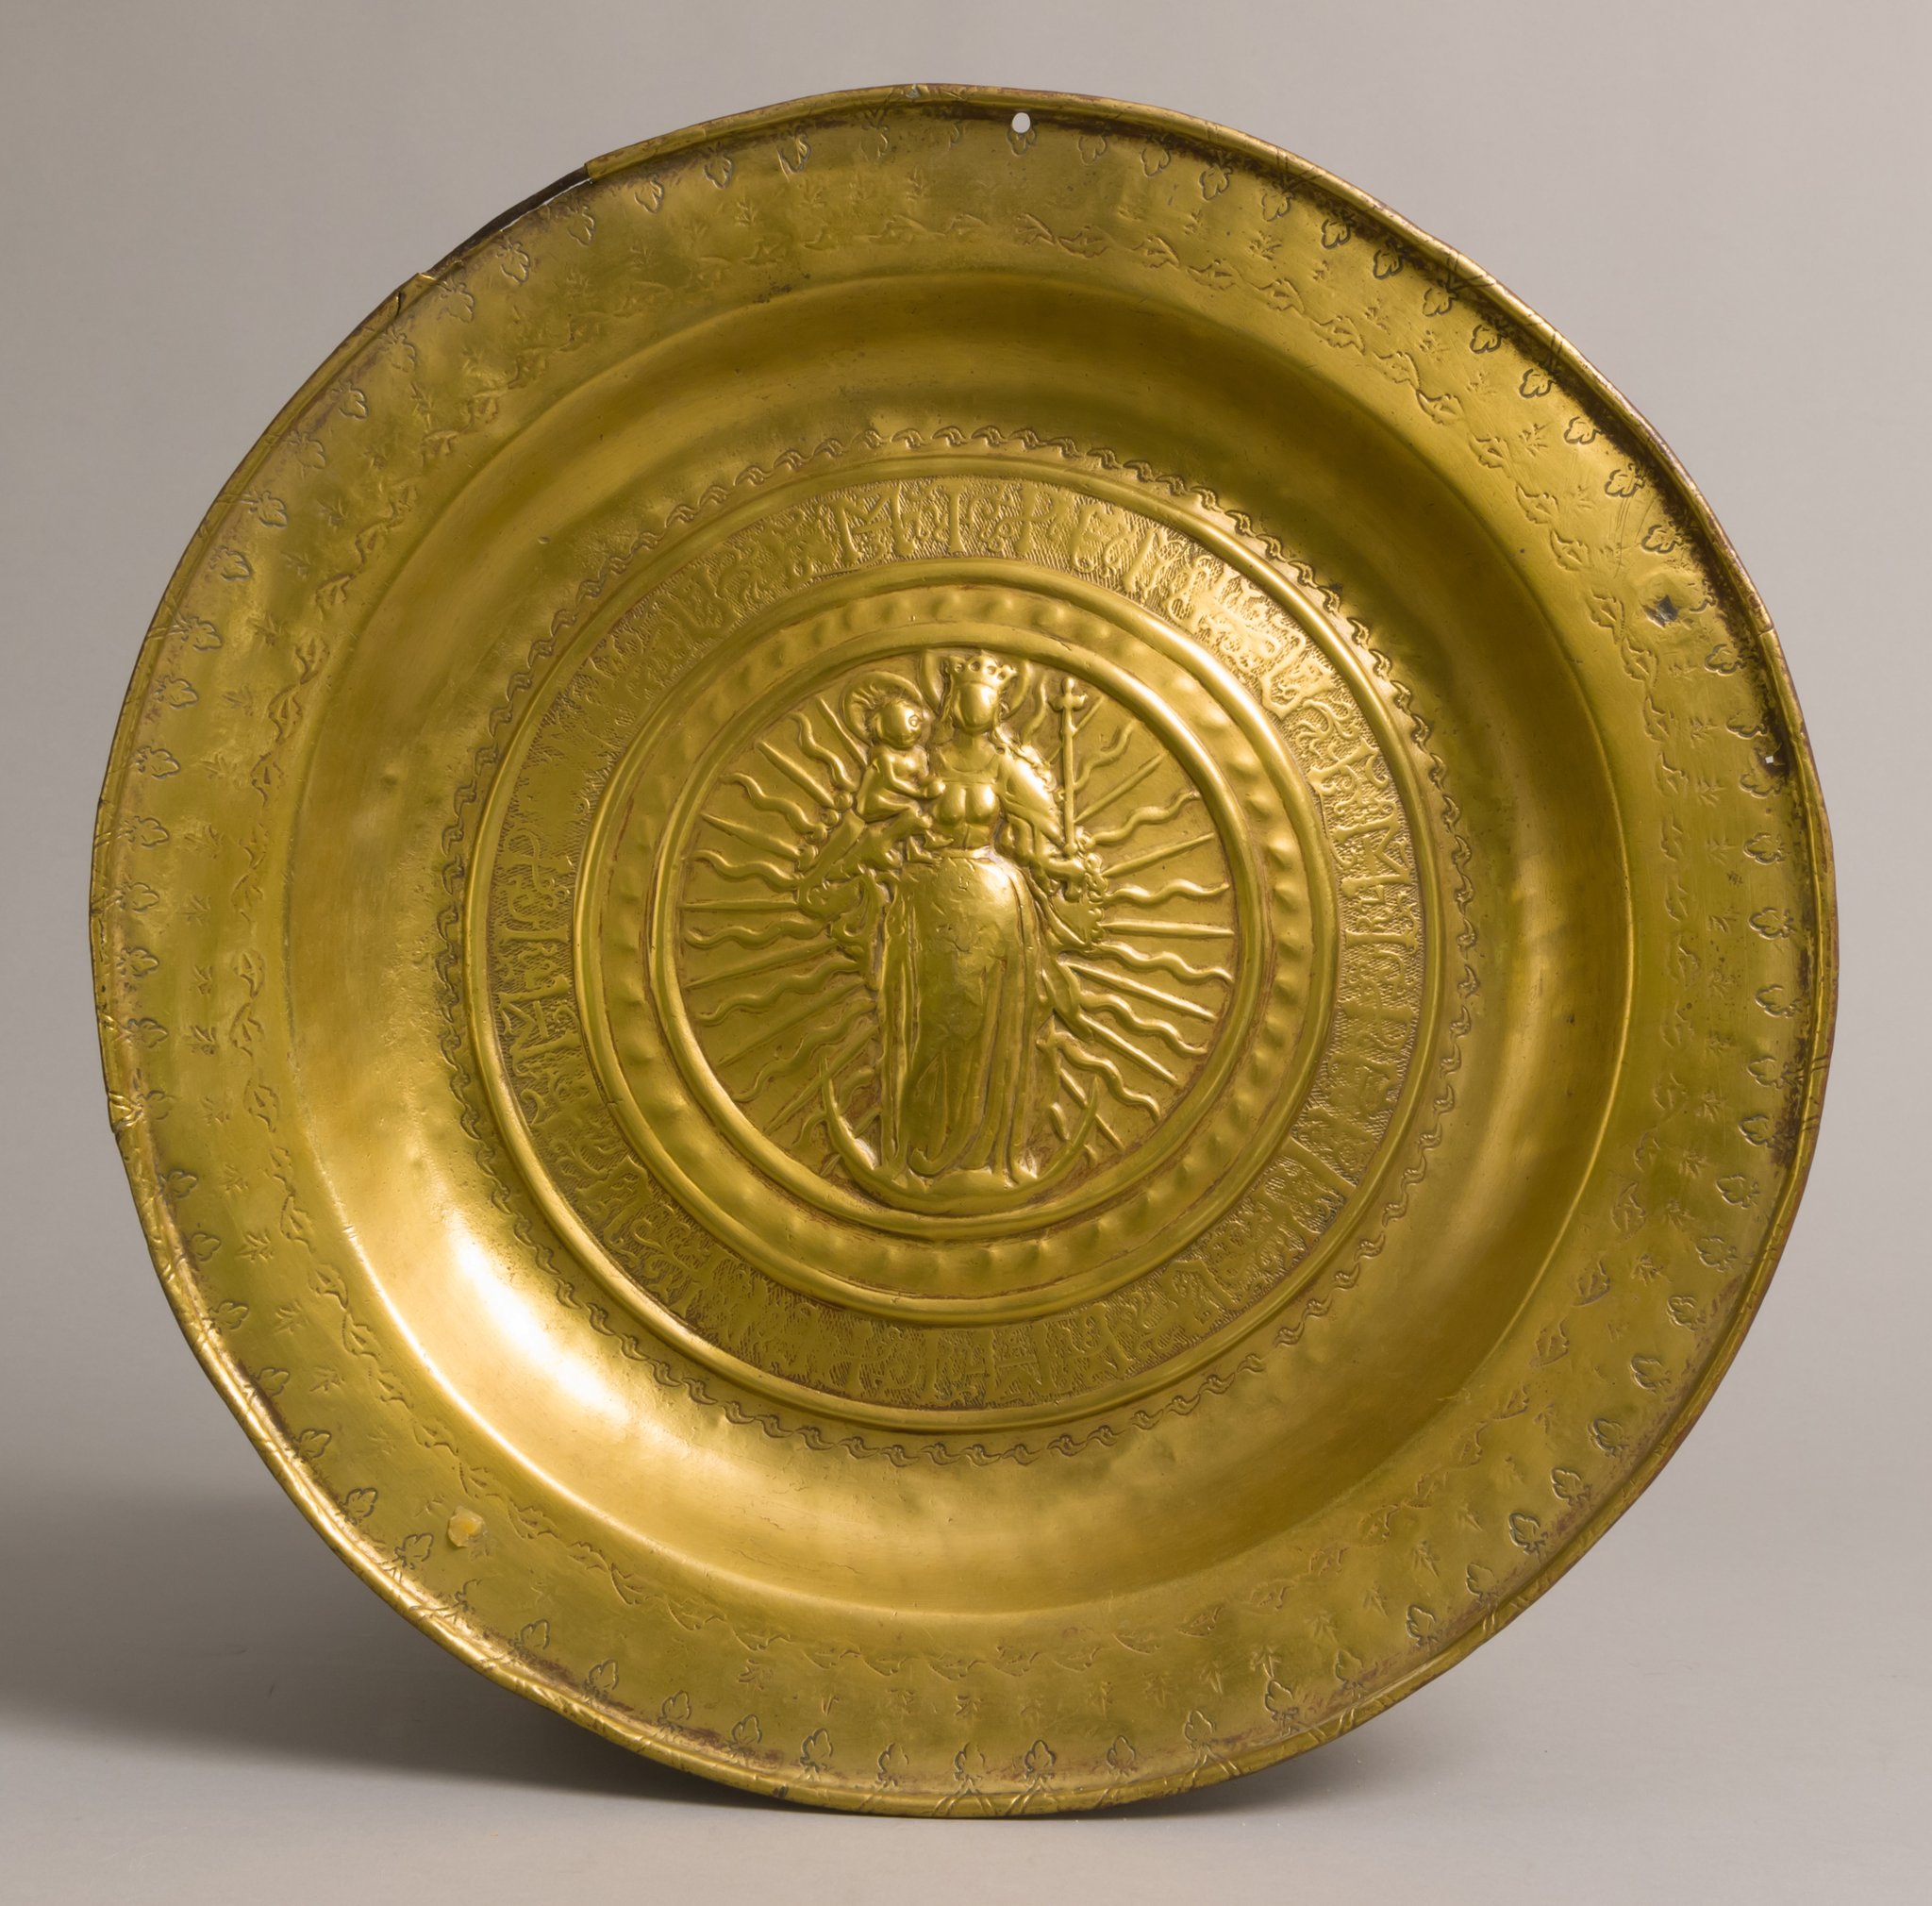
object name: dish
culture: german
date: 1501-1533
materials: brass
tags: madonna and child